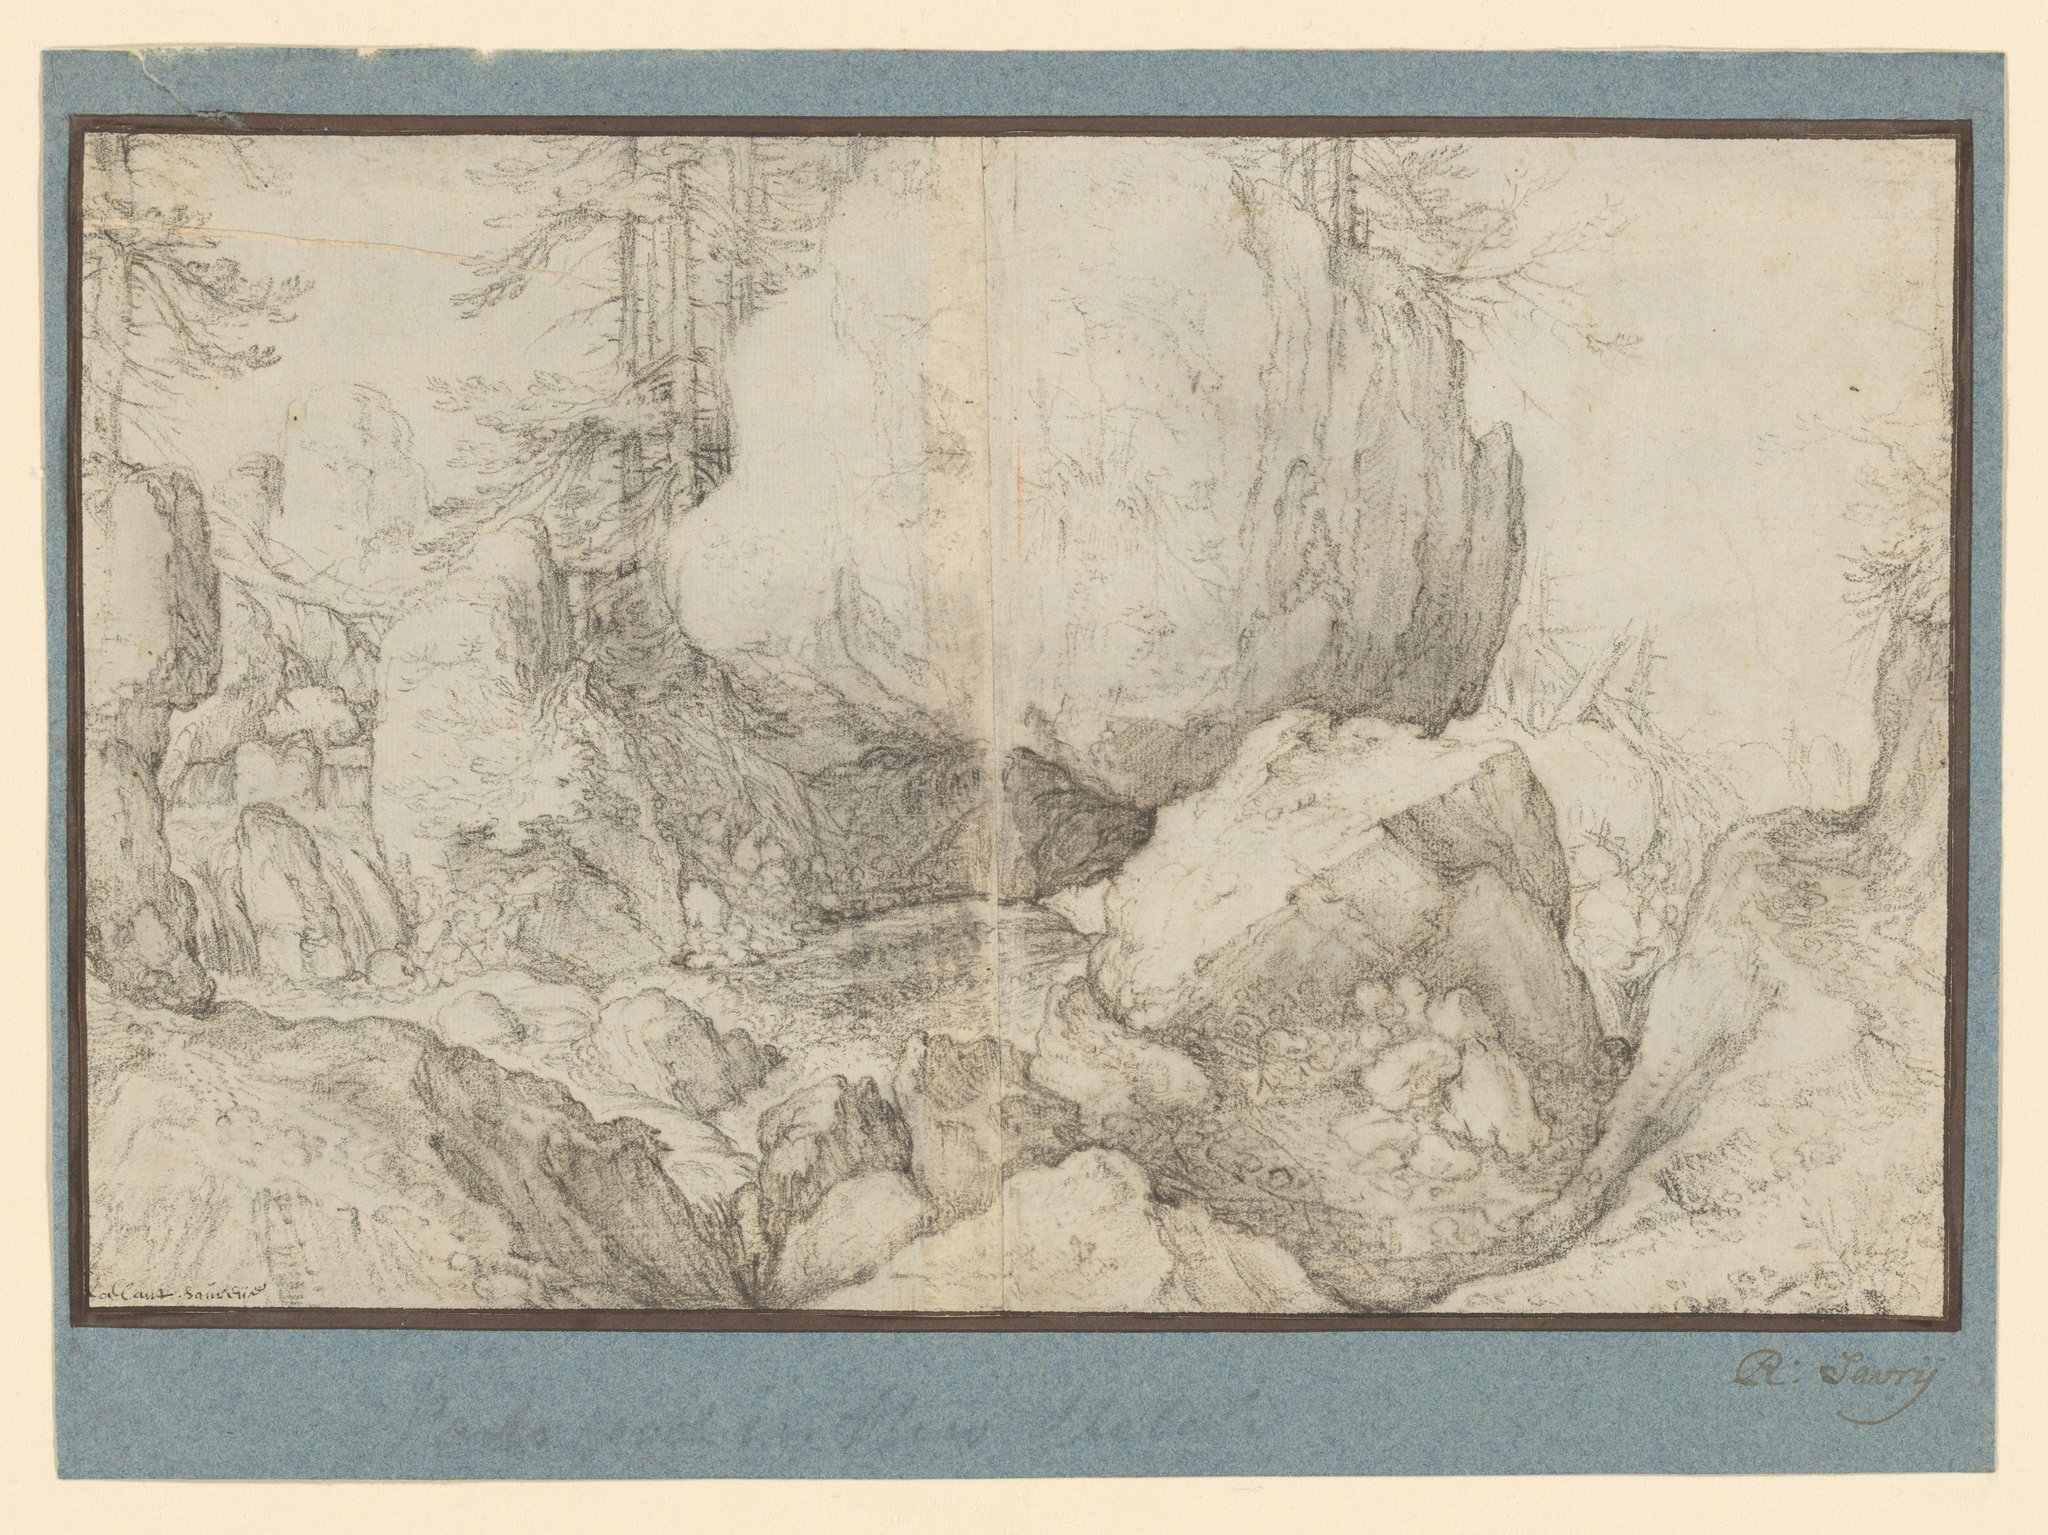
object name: drawing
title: Rotslandschap met rivier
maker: roelant savery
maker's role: draughtsman, painter, print maker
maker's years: 1576-1639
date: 1606-1608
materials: chalk, paper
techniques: drawing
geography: tirol